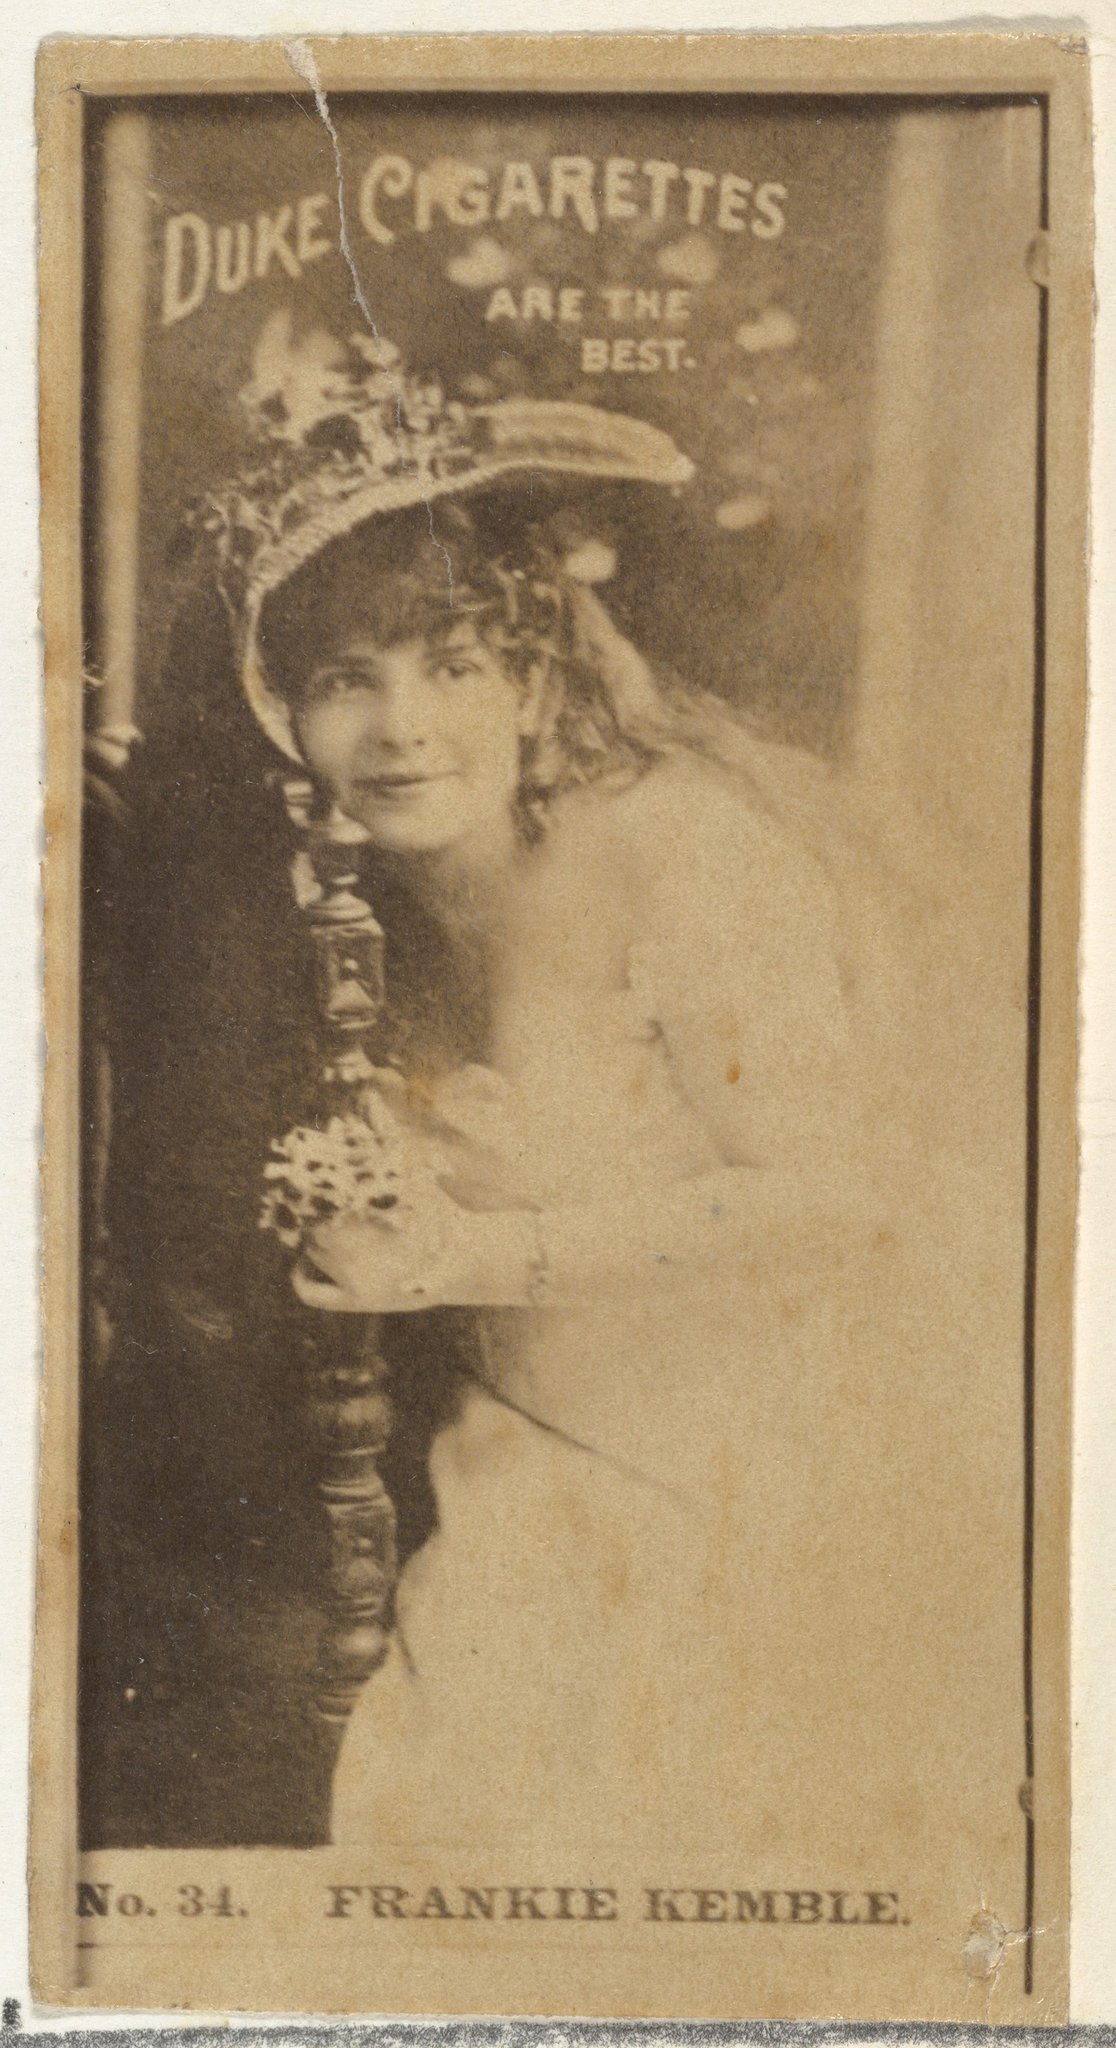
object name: photograph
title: Card Number 34, Frankie Kemble, from the Actors and Actresses series (N145-6) issued by Duke Sons & Co. to promote Duke Cigarettes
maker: w. duke, sons & co.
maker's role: publisher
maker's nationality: american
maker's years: 1870-1920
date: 1880-1889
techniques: albumen silver print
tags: portraits,women,actresses